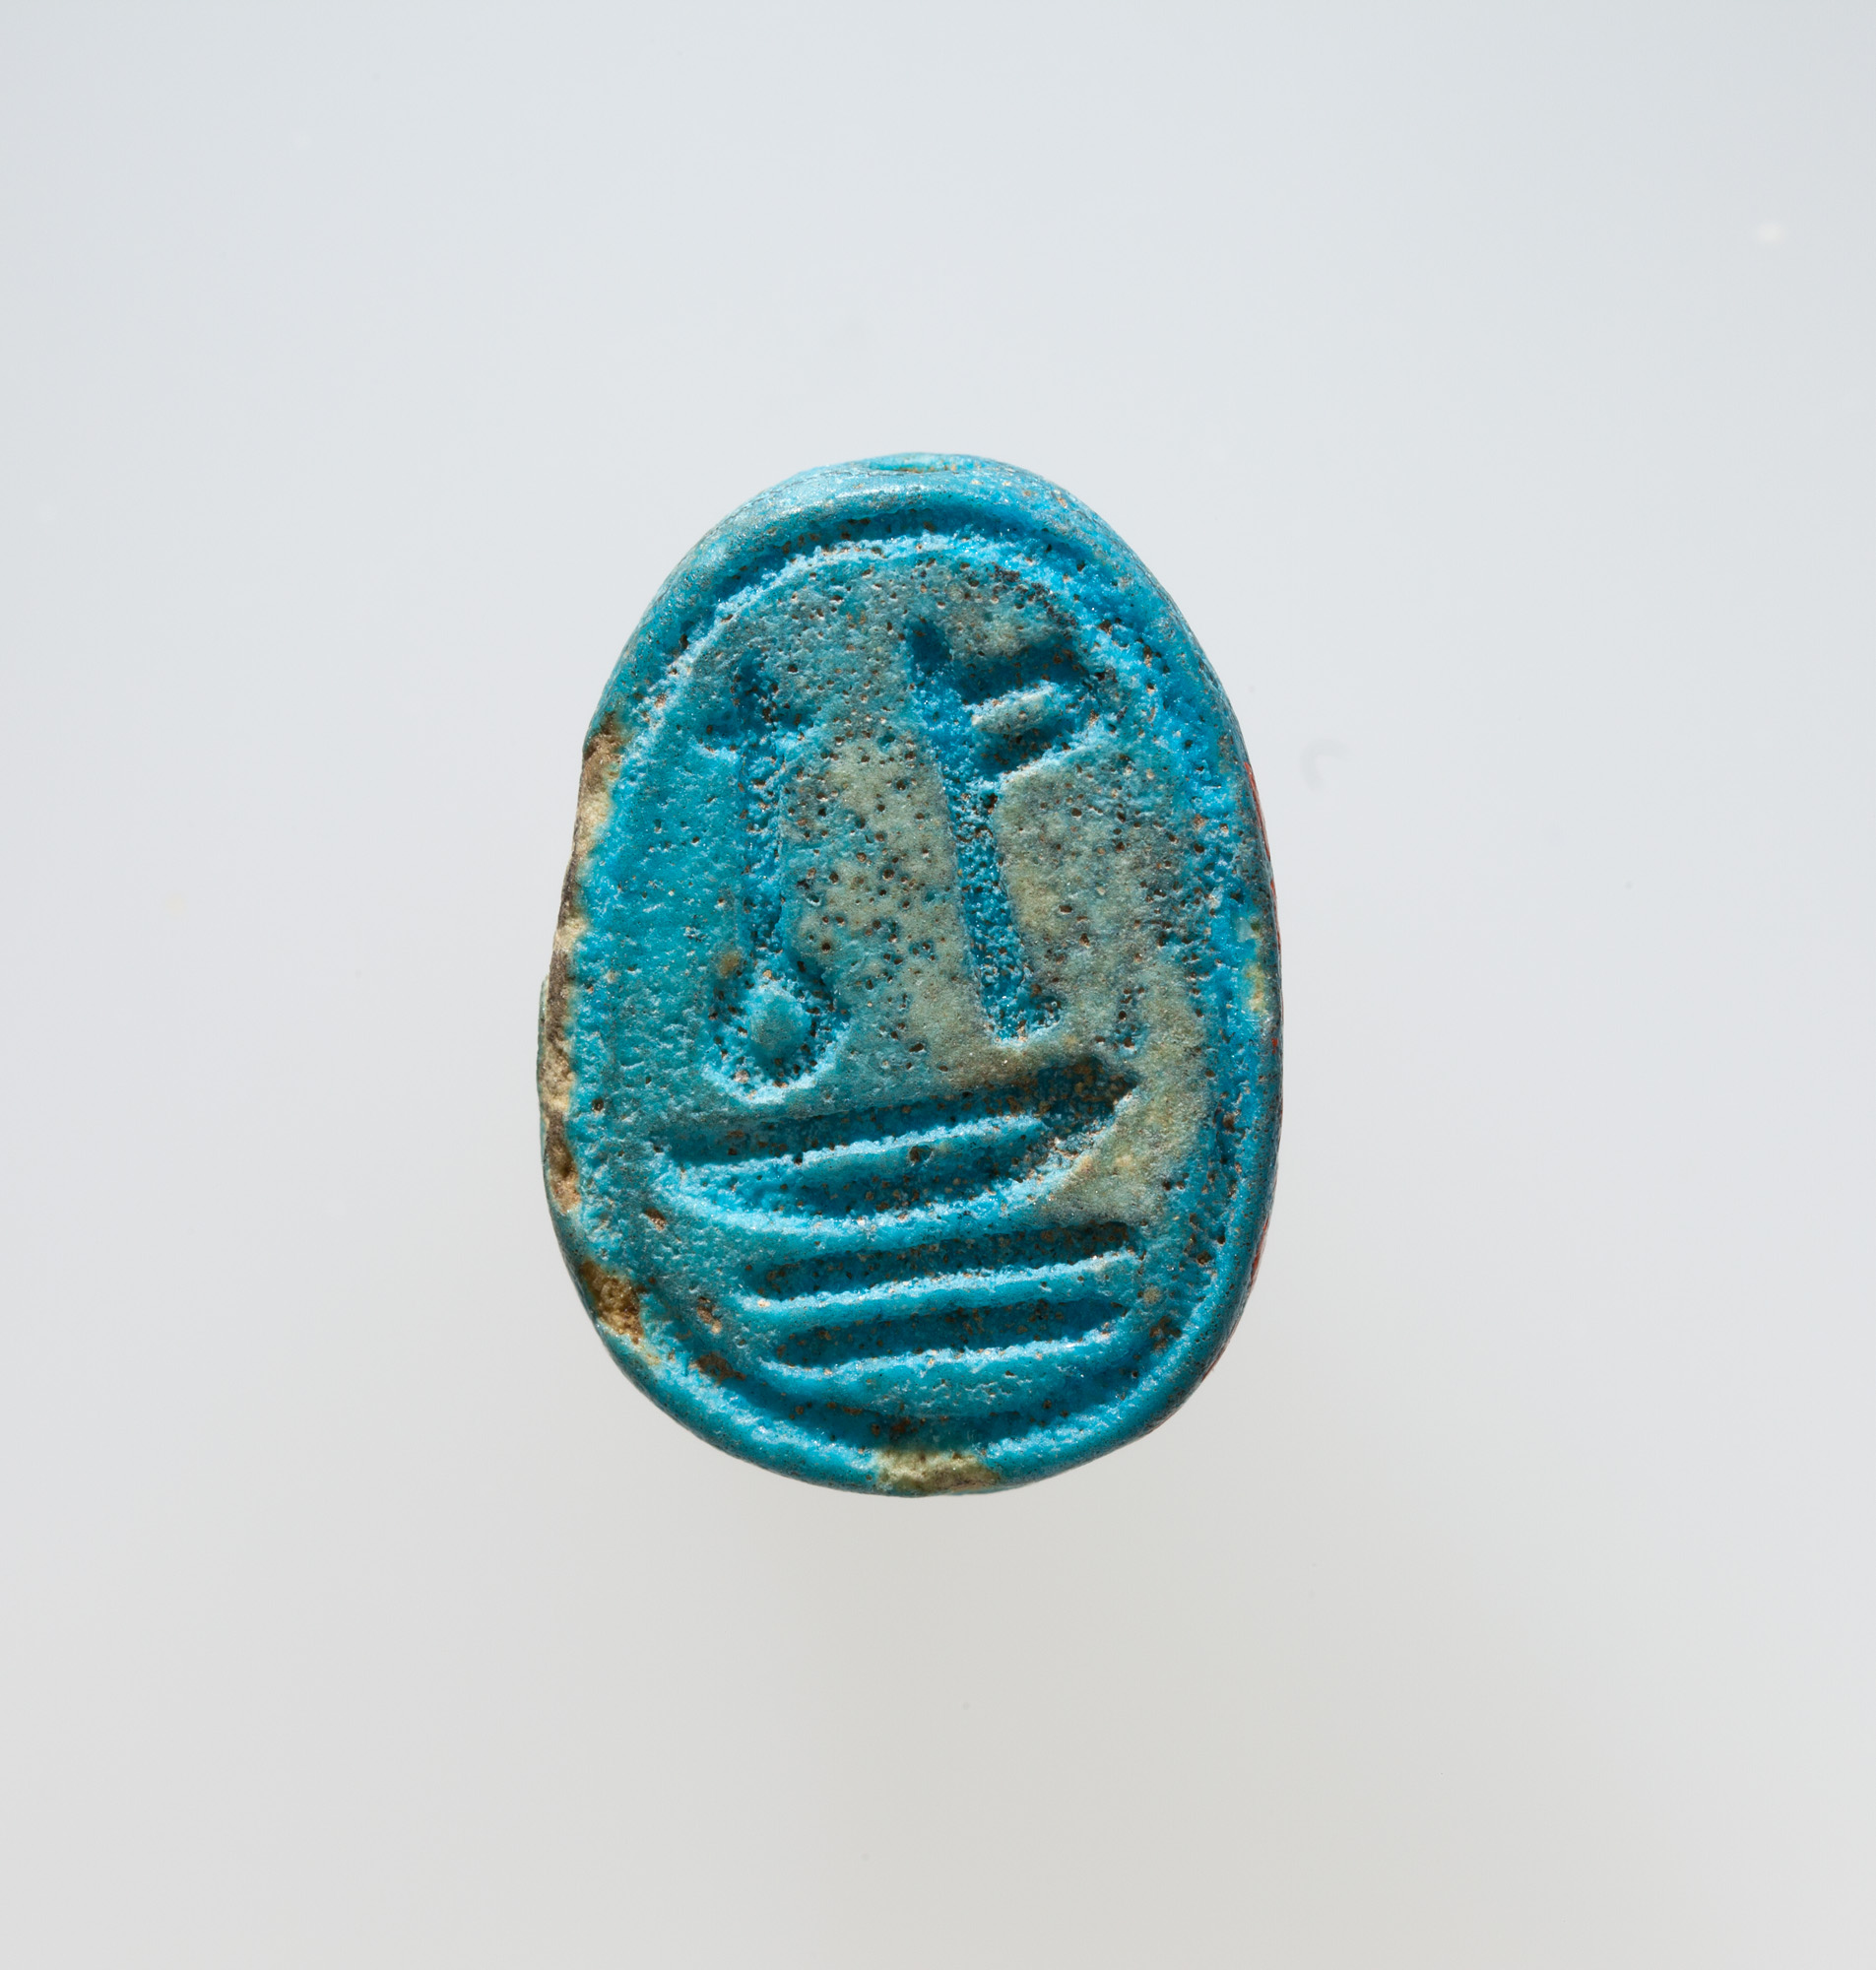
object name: scarab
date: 1479-1458 BCE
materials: faience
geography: egypt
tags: scarabs